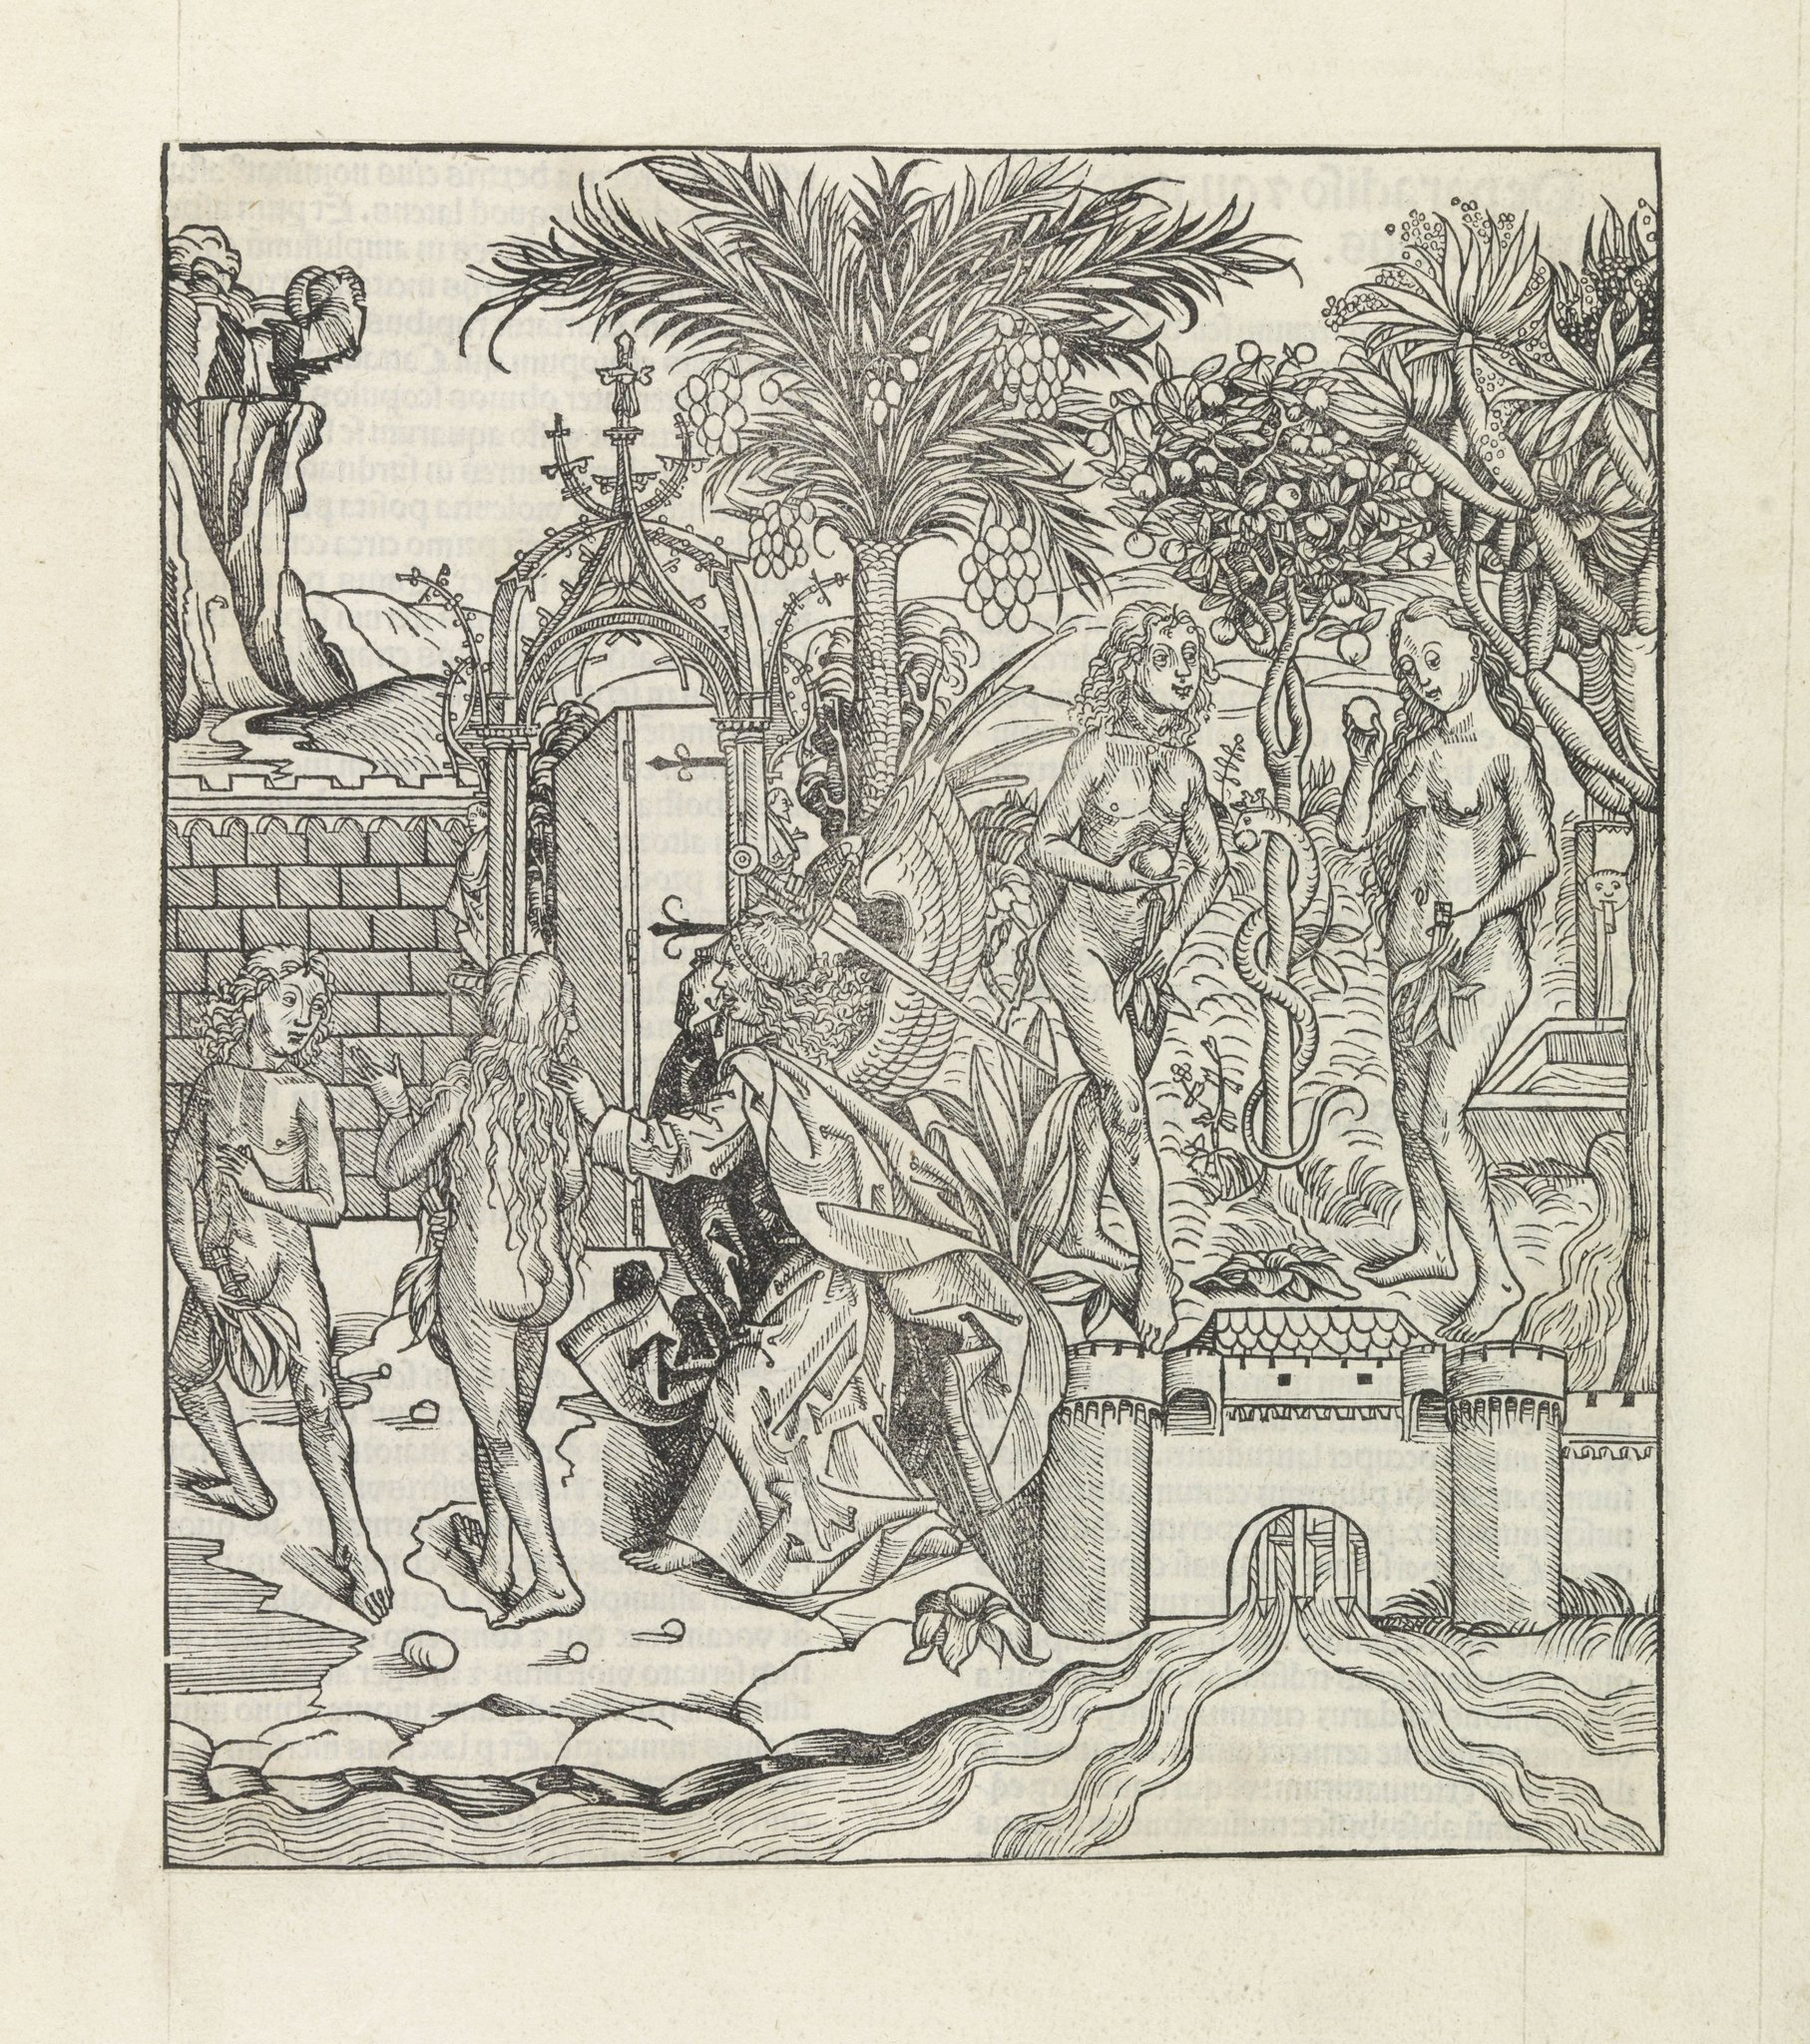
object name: album leaf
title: Verzoeking en Verdrijving uit het Paradijs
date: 1493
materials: paper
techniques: letterpress printing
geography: nuremberg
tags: adam and eve holding (and possibly eating) the fruit, an angel chases adam and eve out of paradise with a (flaming) sword, adam and eve discover their nakedness; they cover themselves with their hands or with leaves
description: Adam en Eva staan naast de boom der kennis van goed en kwaad. Ze hebben al van de appel gegeten en bedekken zich met vijgenbladeren. De slang kronkelt zich om de stam van de boom. Links worden Adam en Eva door een engel met een zwaard uit het paradijs verdreven. De prent maakt deel uit van een album.